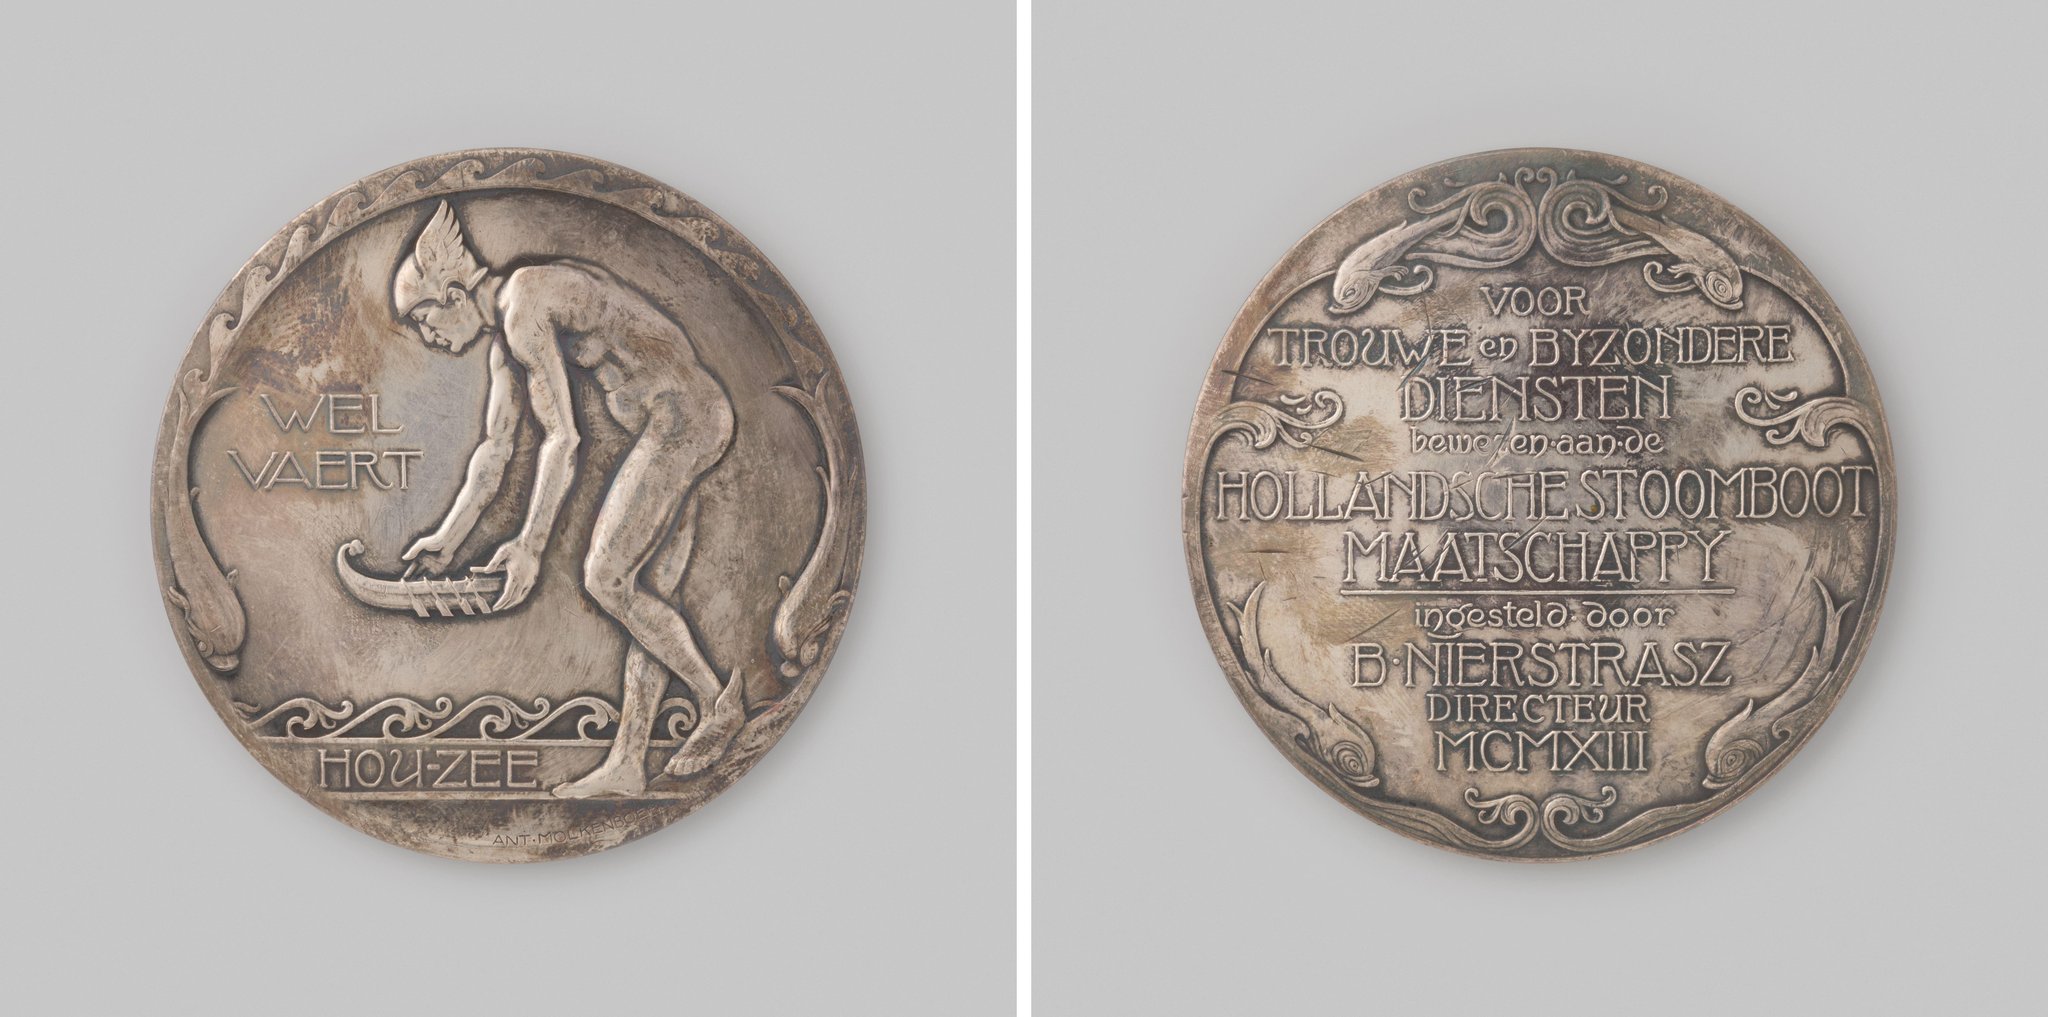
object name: honorary medal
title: Honorary Medal of the Dutch Steamship Company for Loyalty and Special Service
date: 1913-1914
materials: plastic, silver, textile, velvet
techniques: striking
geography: utrecht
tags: b. nierstrasz, hollandsche stoomboot maatschappij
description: People who have performed a heroic deed or reached the end of a long career are sometimes awarded a medal as a token of esteem and gratitude. Often these are made of gold. Especially in the seventeenth century, gold medals with their chains were literally a reward. They were subsequently melted down and converted into money, which is why so few have survived.